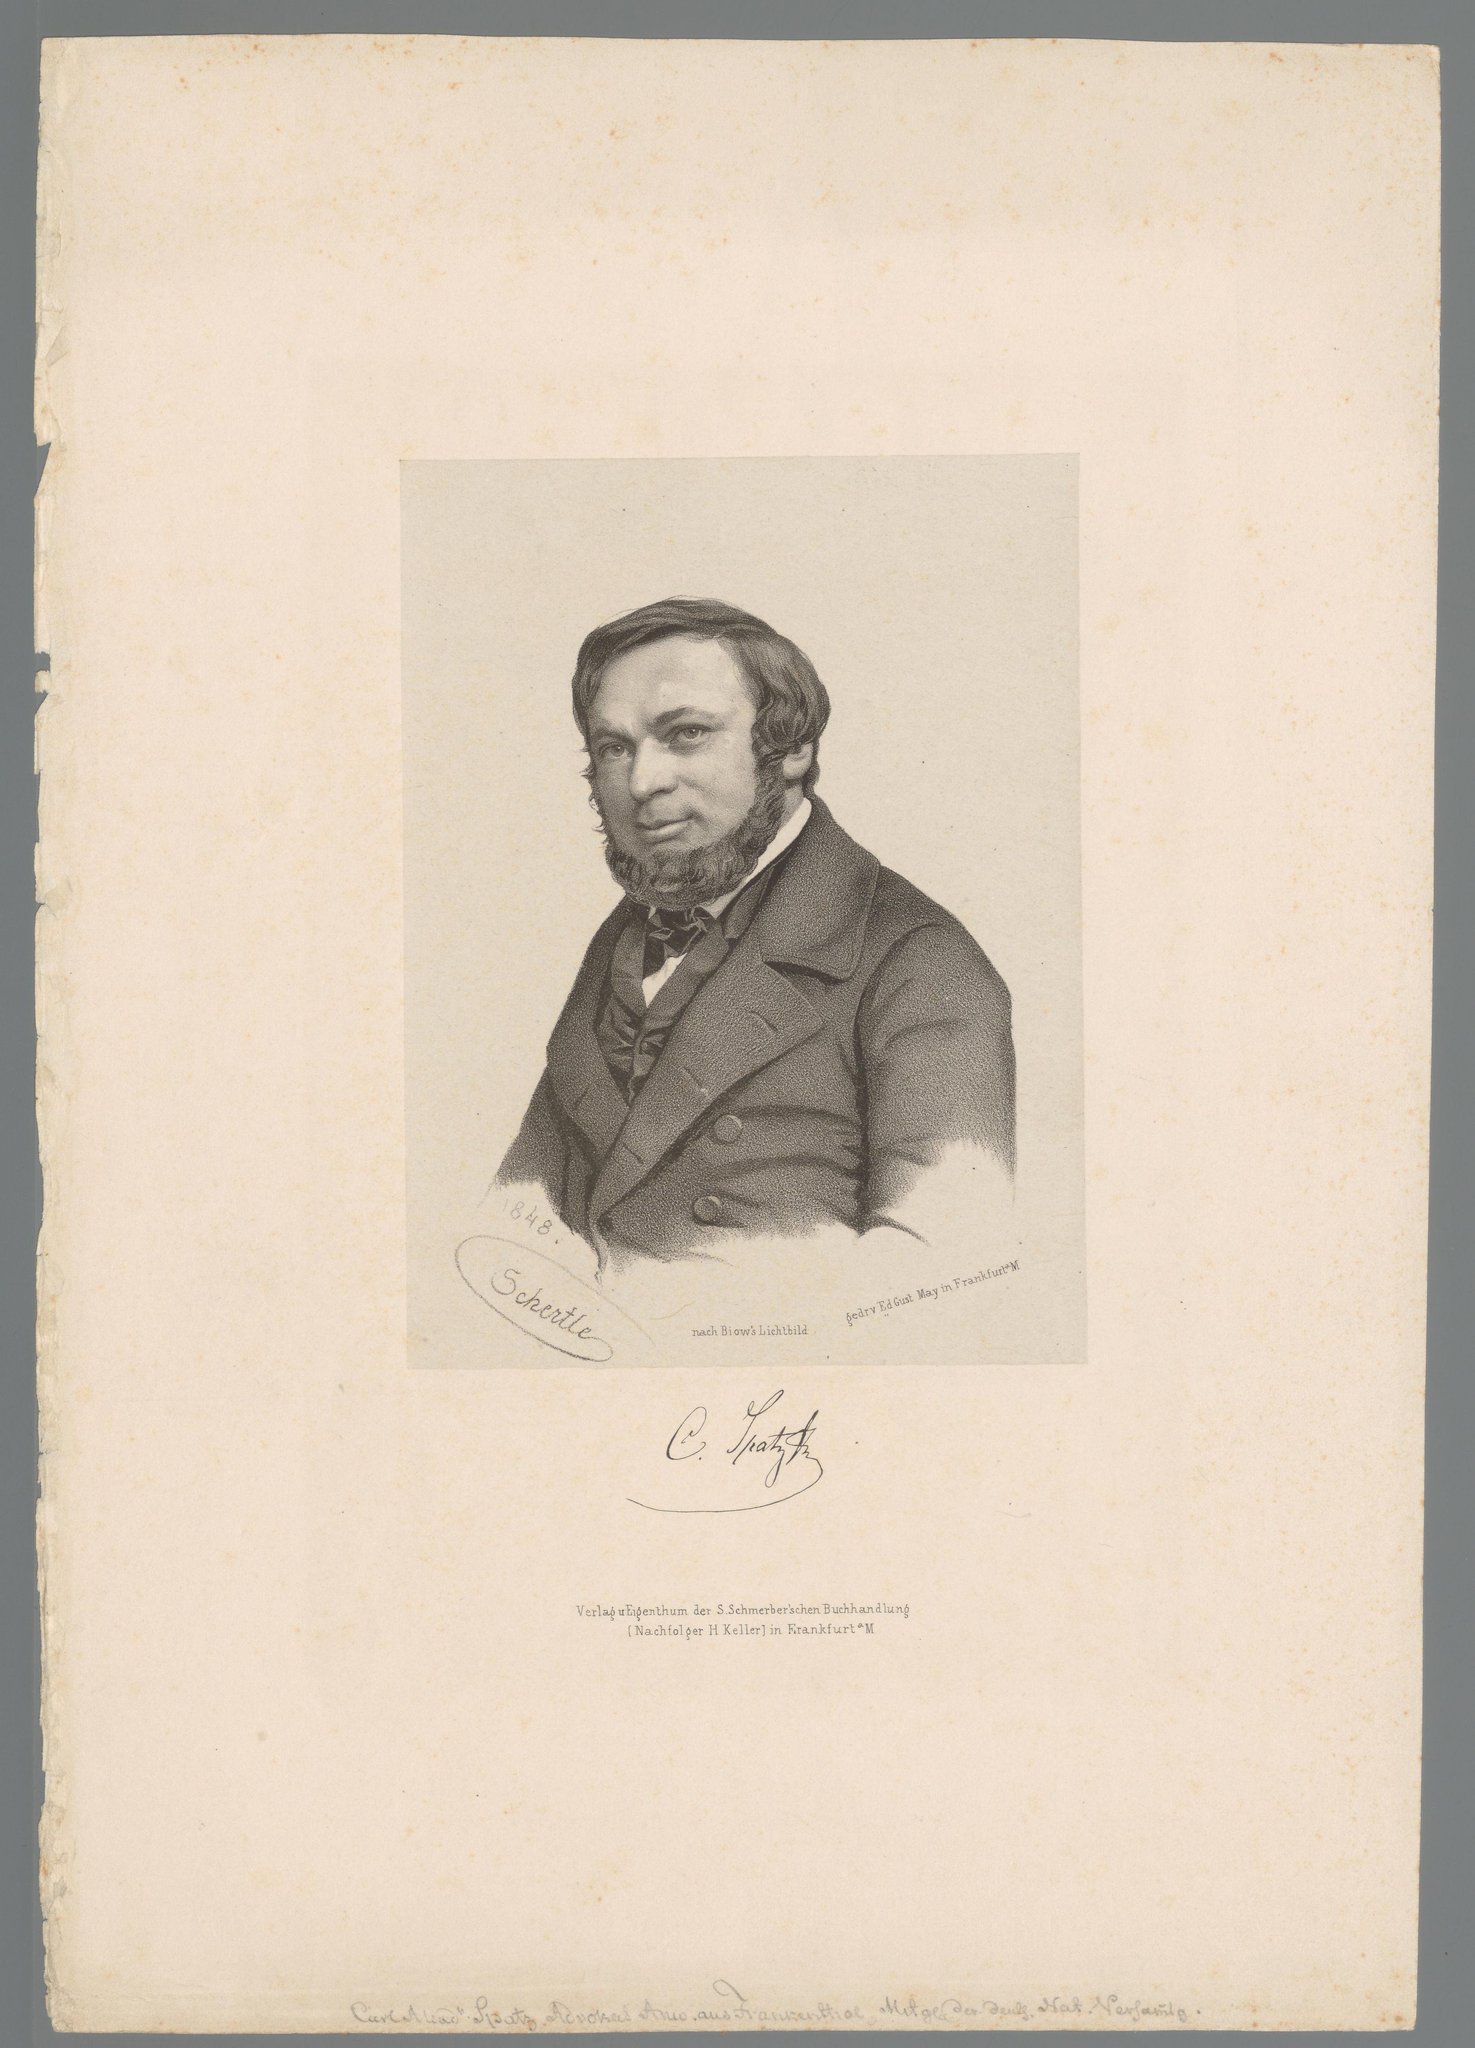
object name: print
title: Portret van Carl Spatz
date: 1848-1849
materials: paper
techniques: lithograph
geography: frankfurt am main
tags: politician, adult man, historical persons, beard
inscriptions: collector's mark: Lugt 2228